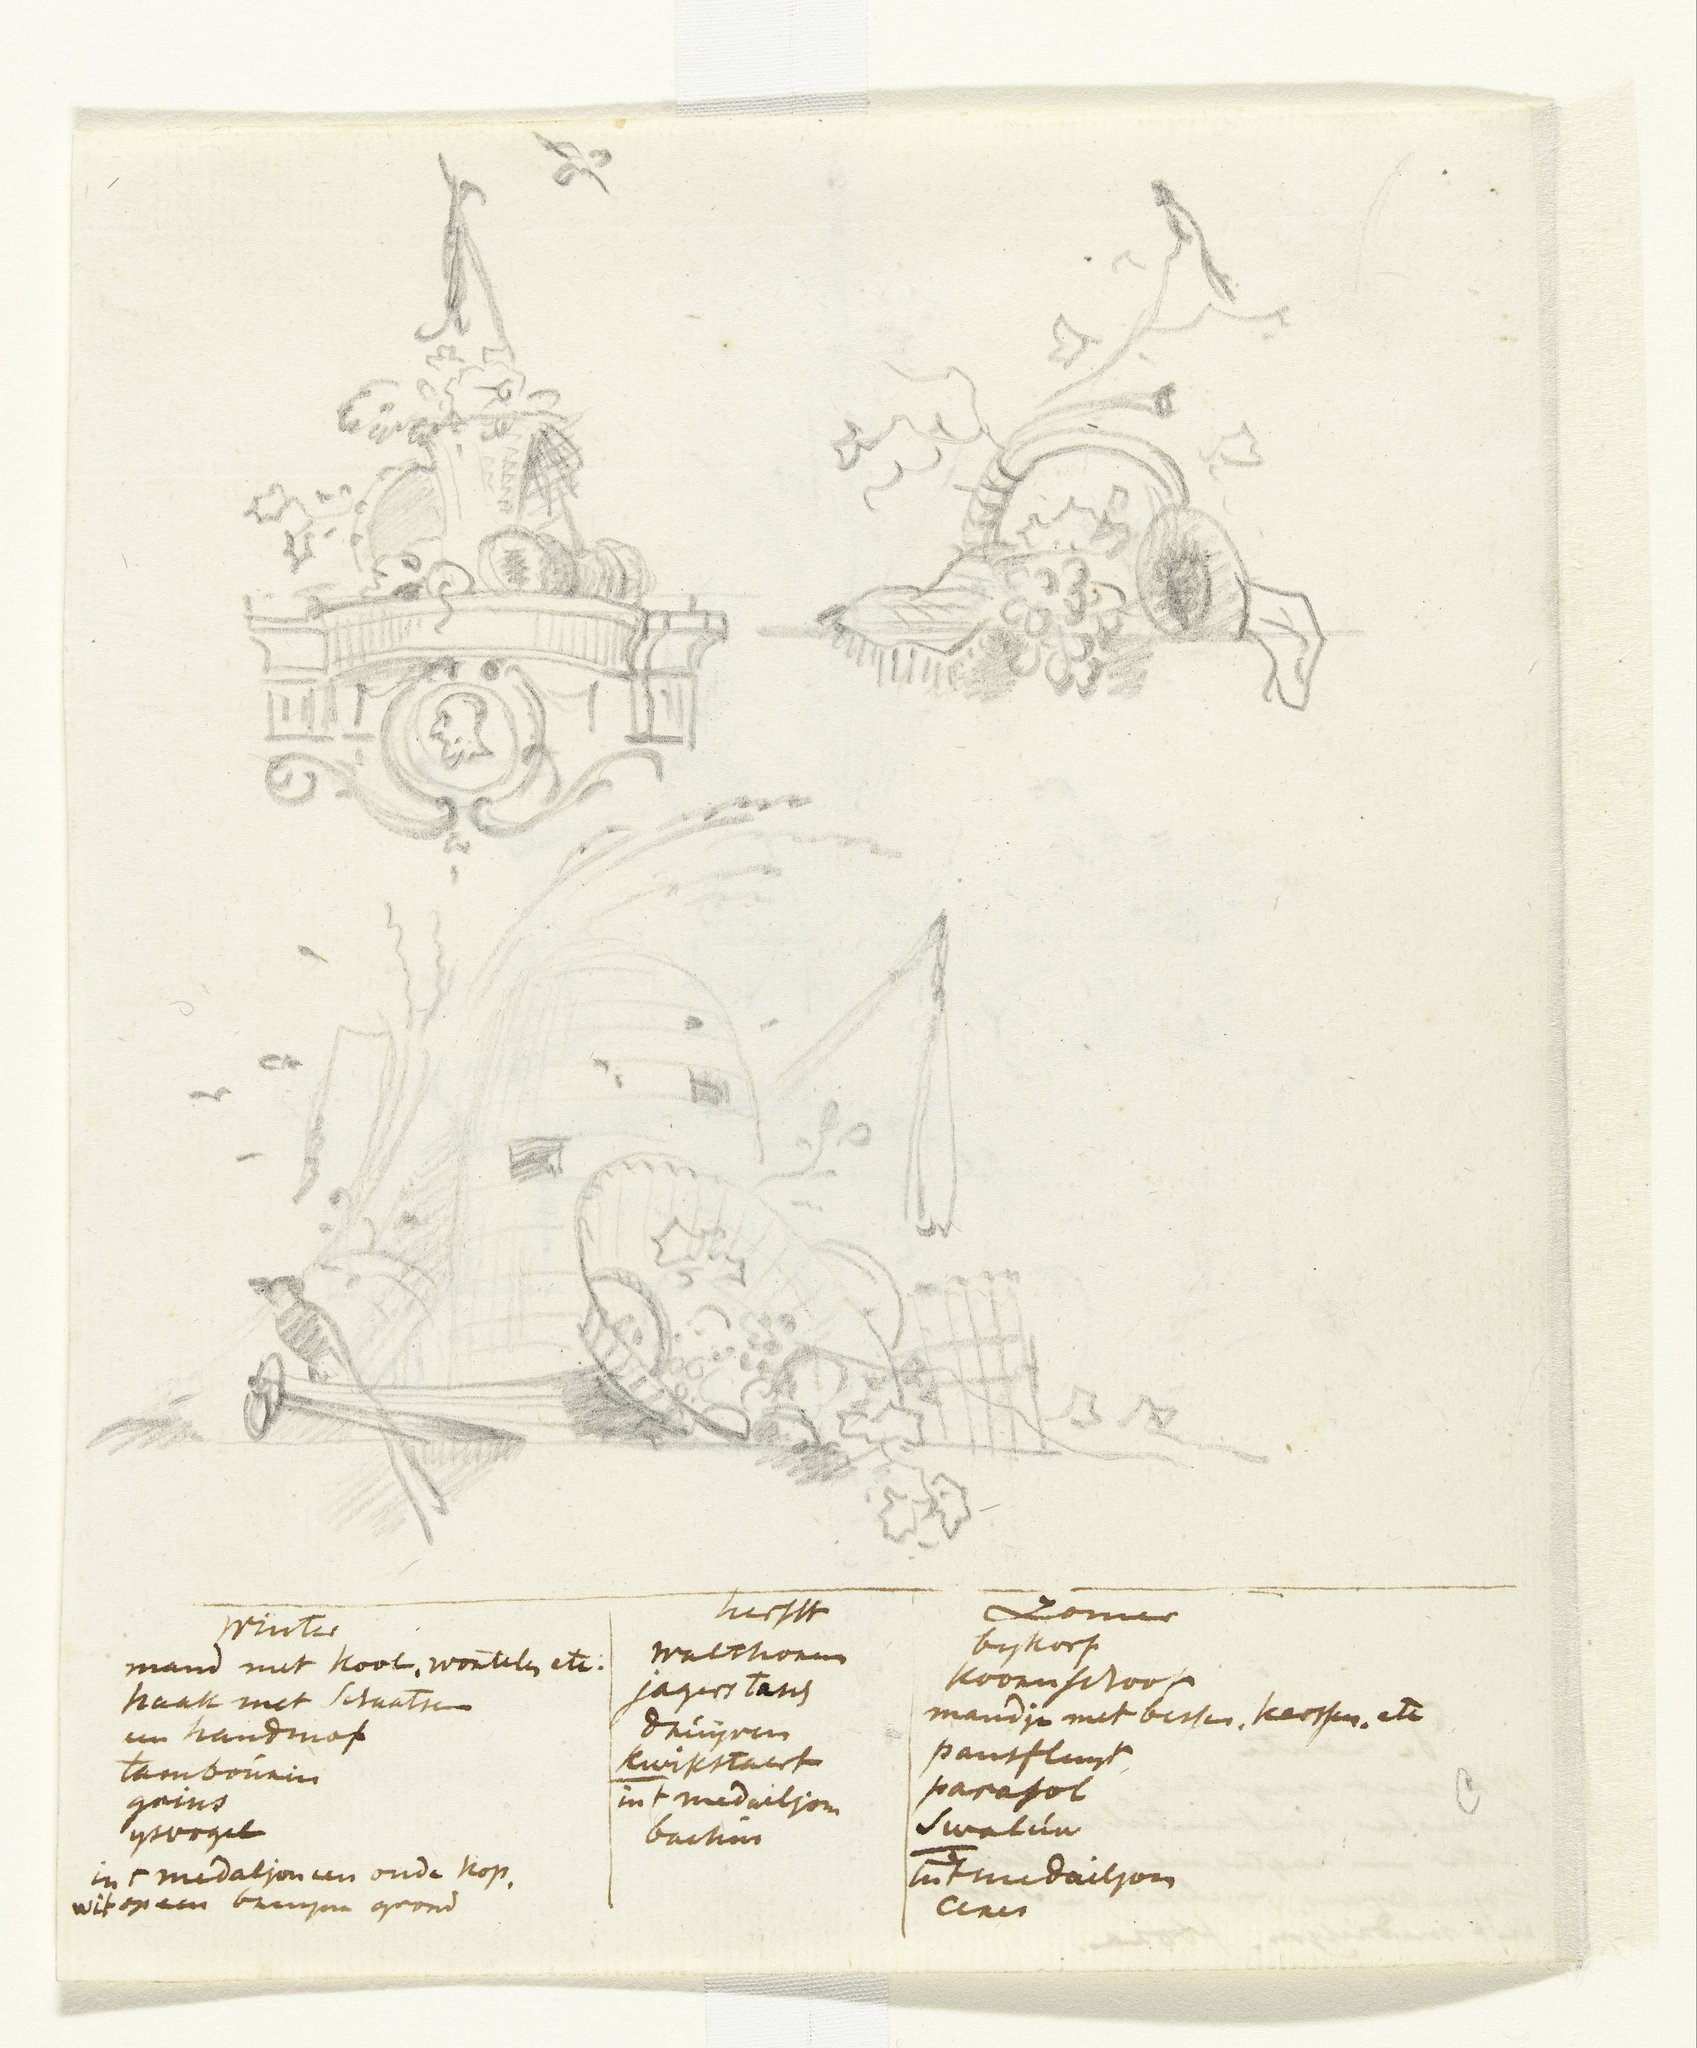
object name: design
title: Ontwerpen voor drie wanddecoraties met allegorieën op de zomer, herfst en winter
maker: jurriaan andriessen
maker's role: draughtsman, painter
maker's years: 1742-1819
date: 1752-1819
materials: graphite, paper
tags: summer, 'aestas'; 'estate' (ripa), winter, 'hyems'; 'inverno' (ripa), autumn, fall, 'autumnus'; 'autunno' (ripa)